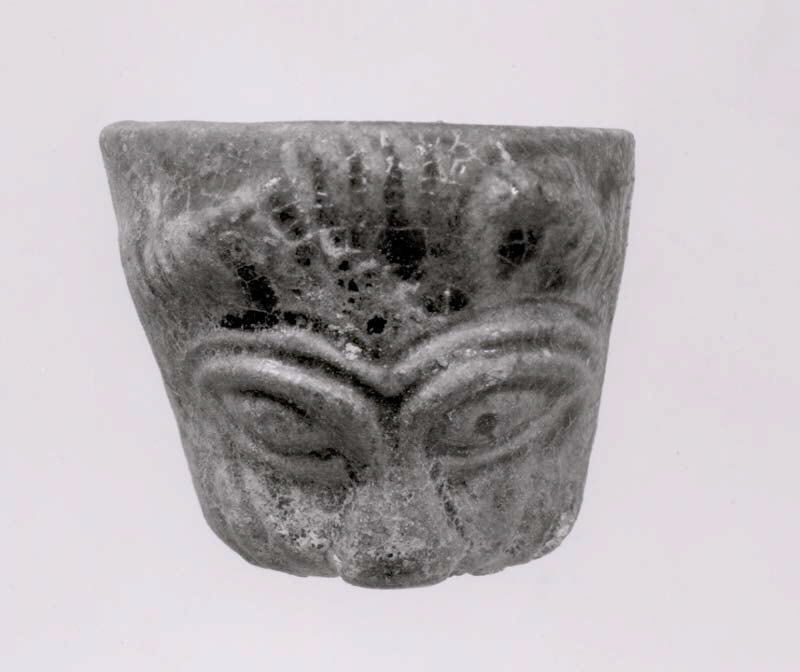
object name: cup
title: Cup in the shape of a lion's head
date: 1700-1501 BCE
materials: faience, glaze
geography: syria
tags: lions